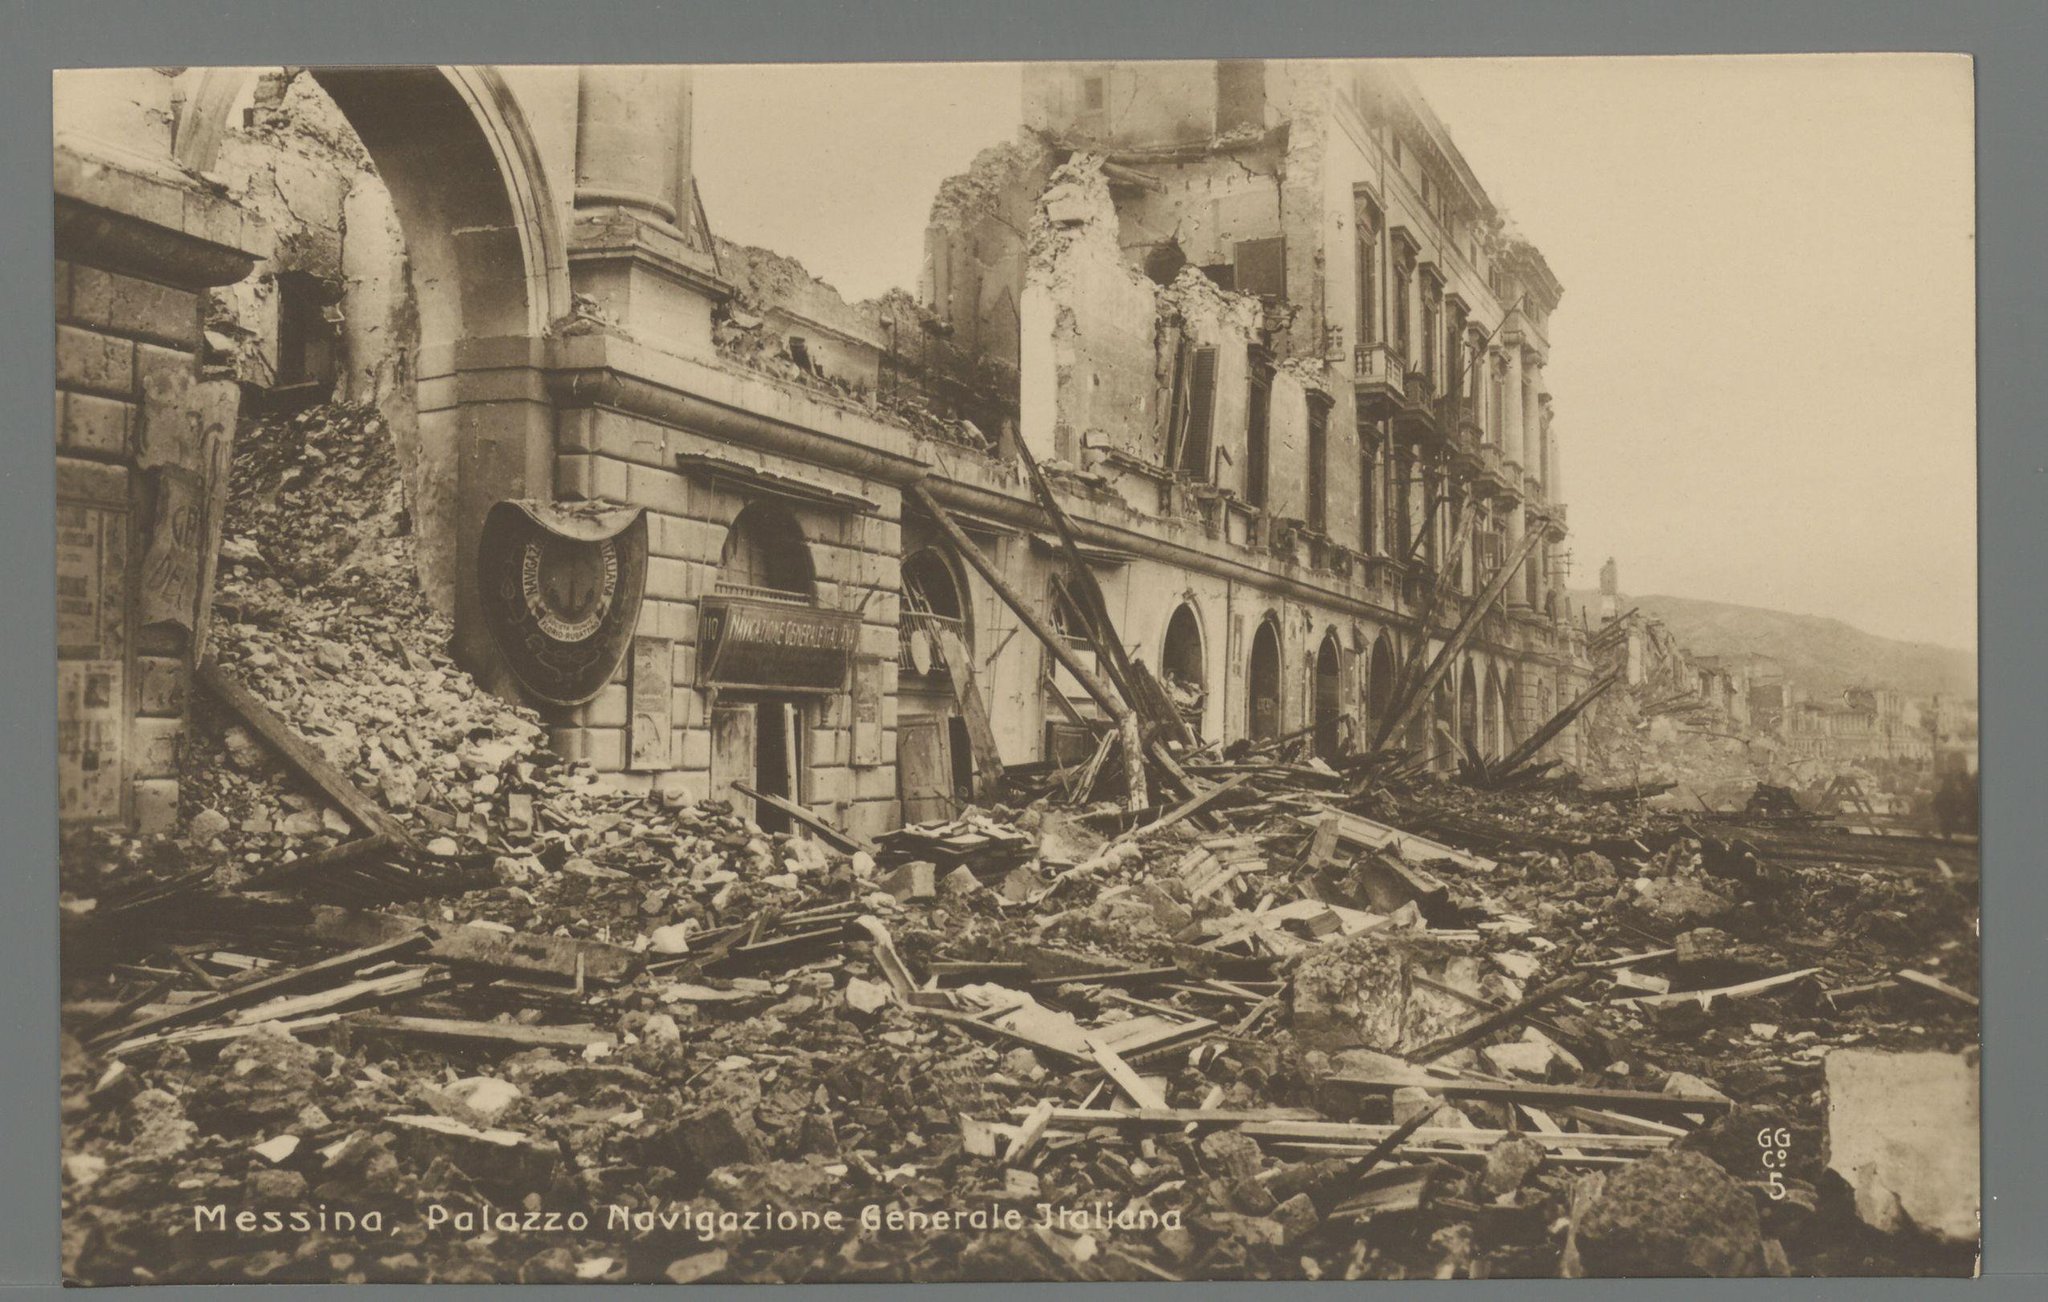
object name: photograph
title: Messina. Palazzo Navigazione Generale Italiana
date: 1908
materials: paper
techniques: gelatin silver print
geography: messina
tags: consequences of an earthquake, collapsing building